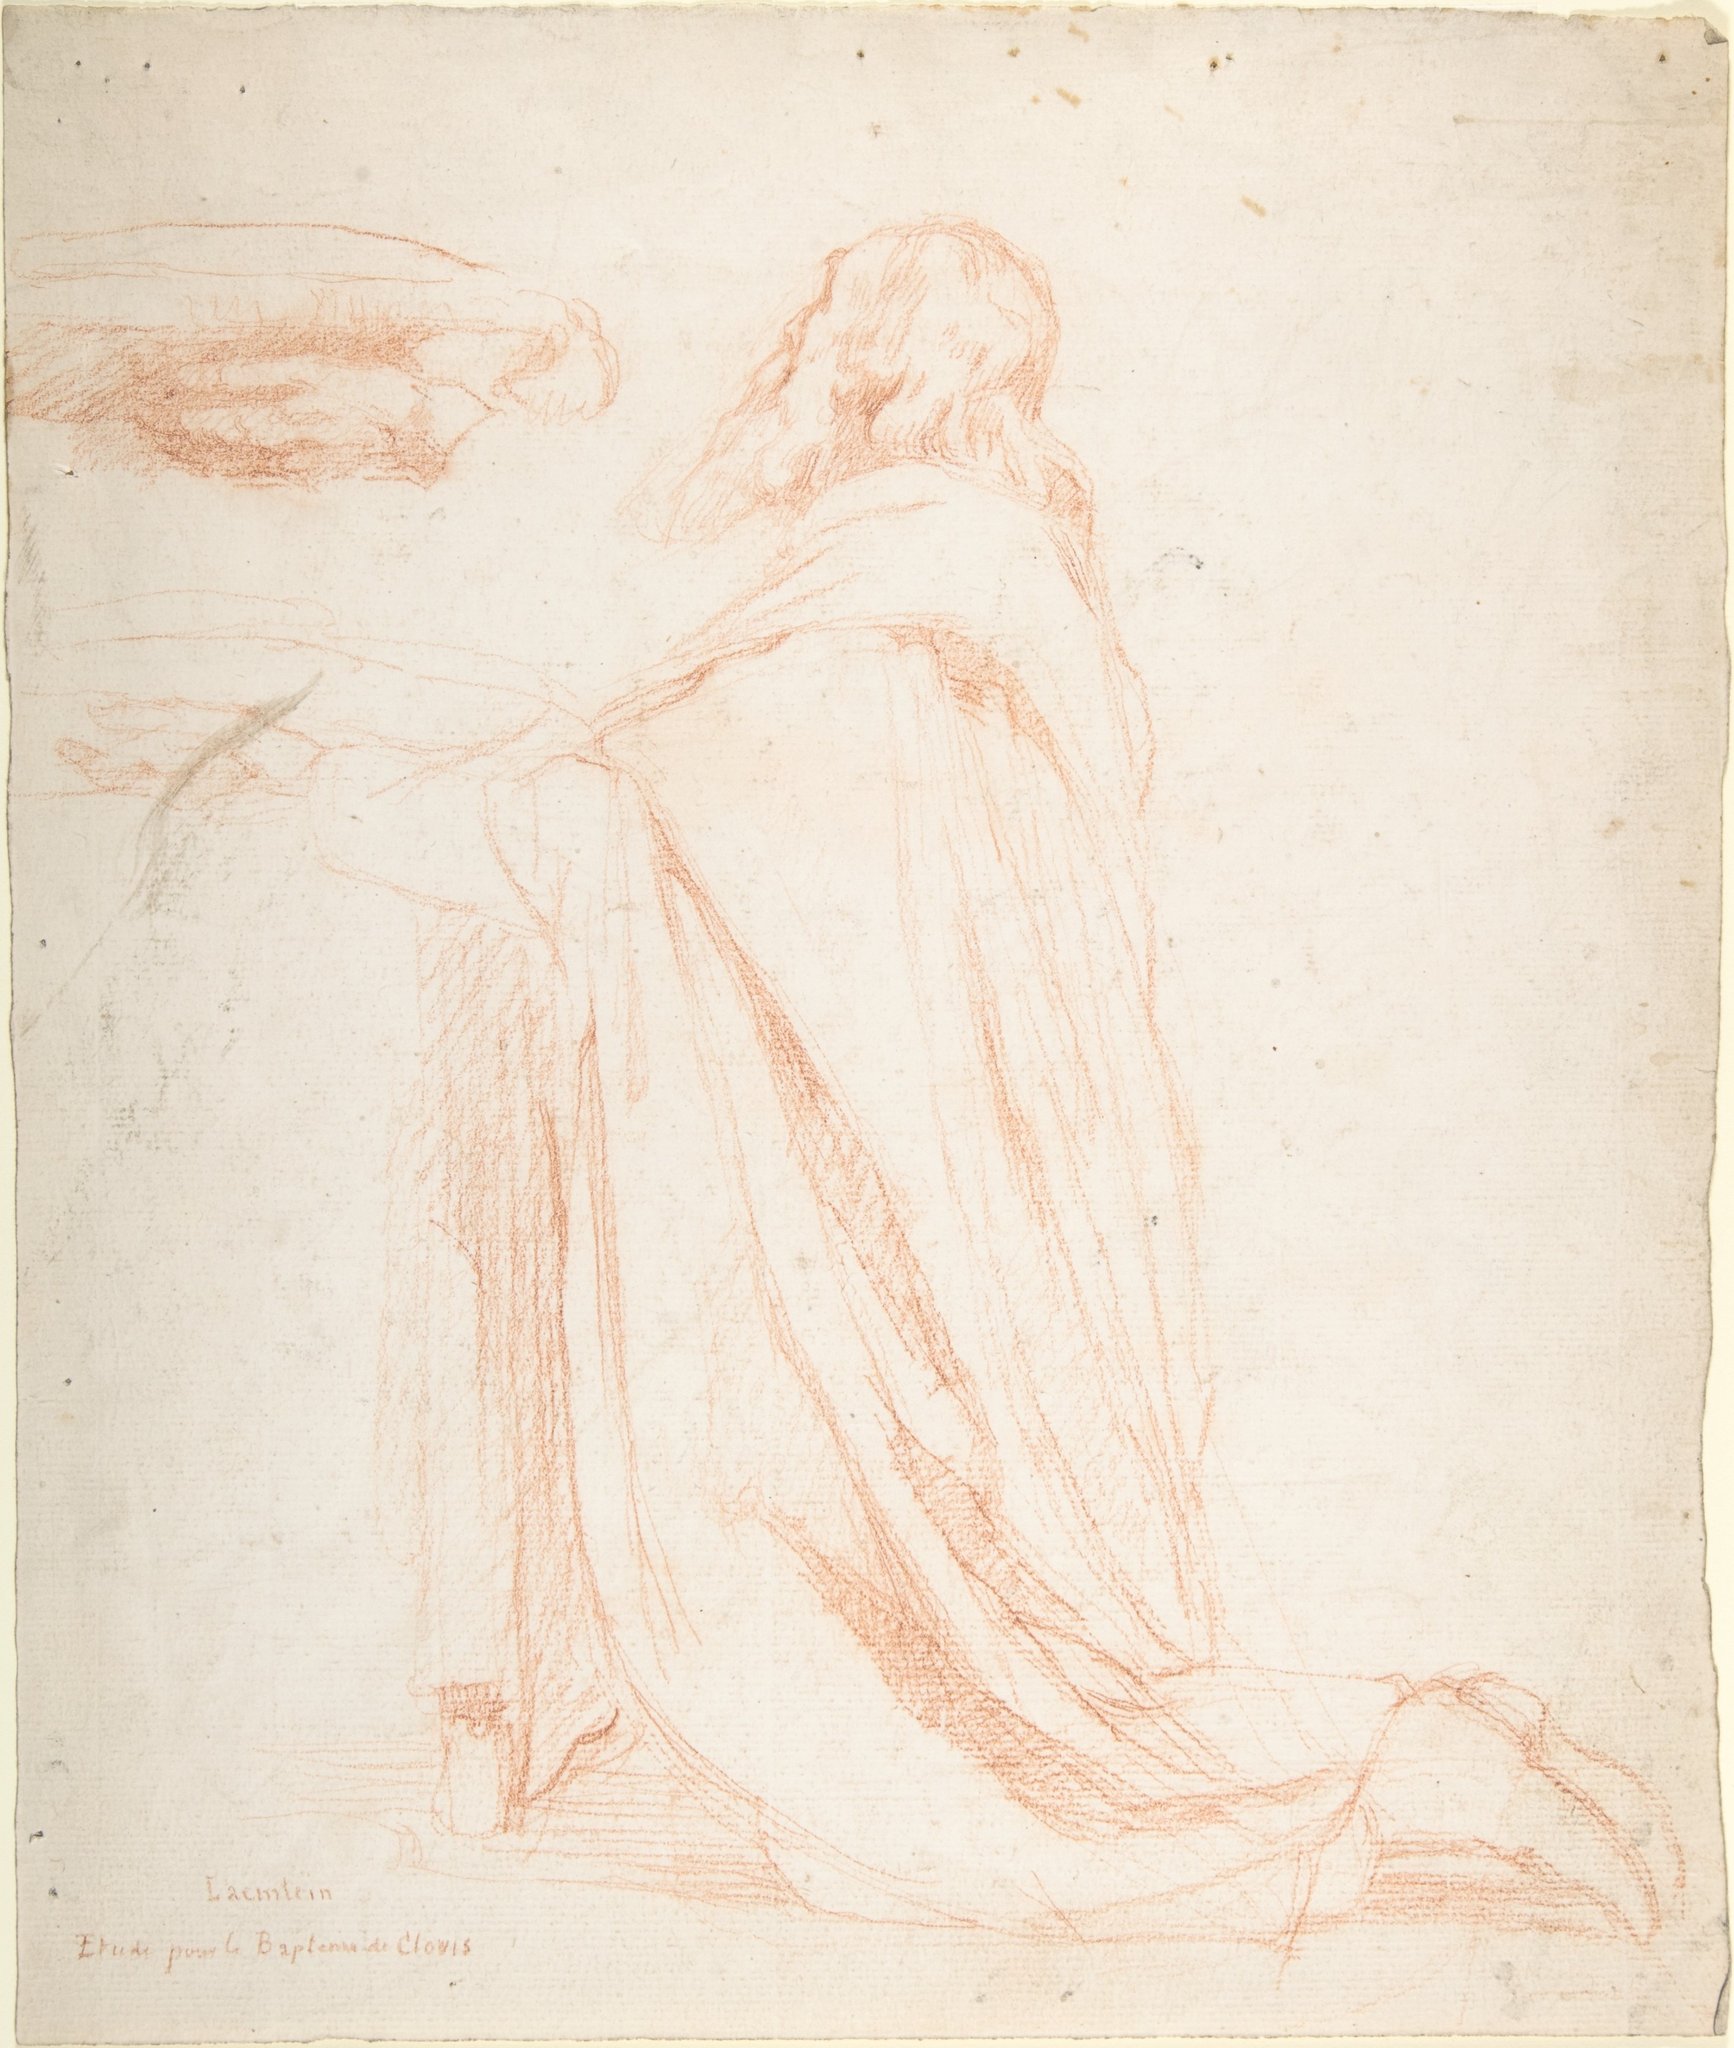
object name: drawing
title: Kneeling Prelate Holding a Cushion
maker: alexandre laemlein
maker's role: artist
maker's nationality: french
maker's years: 1813-1871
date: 1830-1871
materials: chalk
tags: bishops